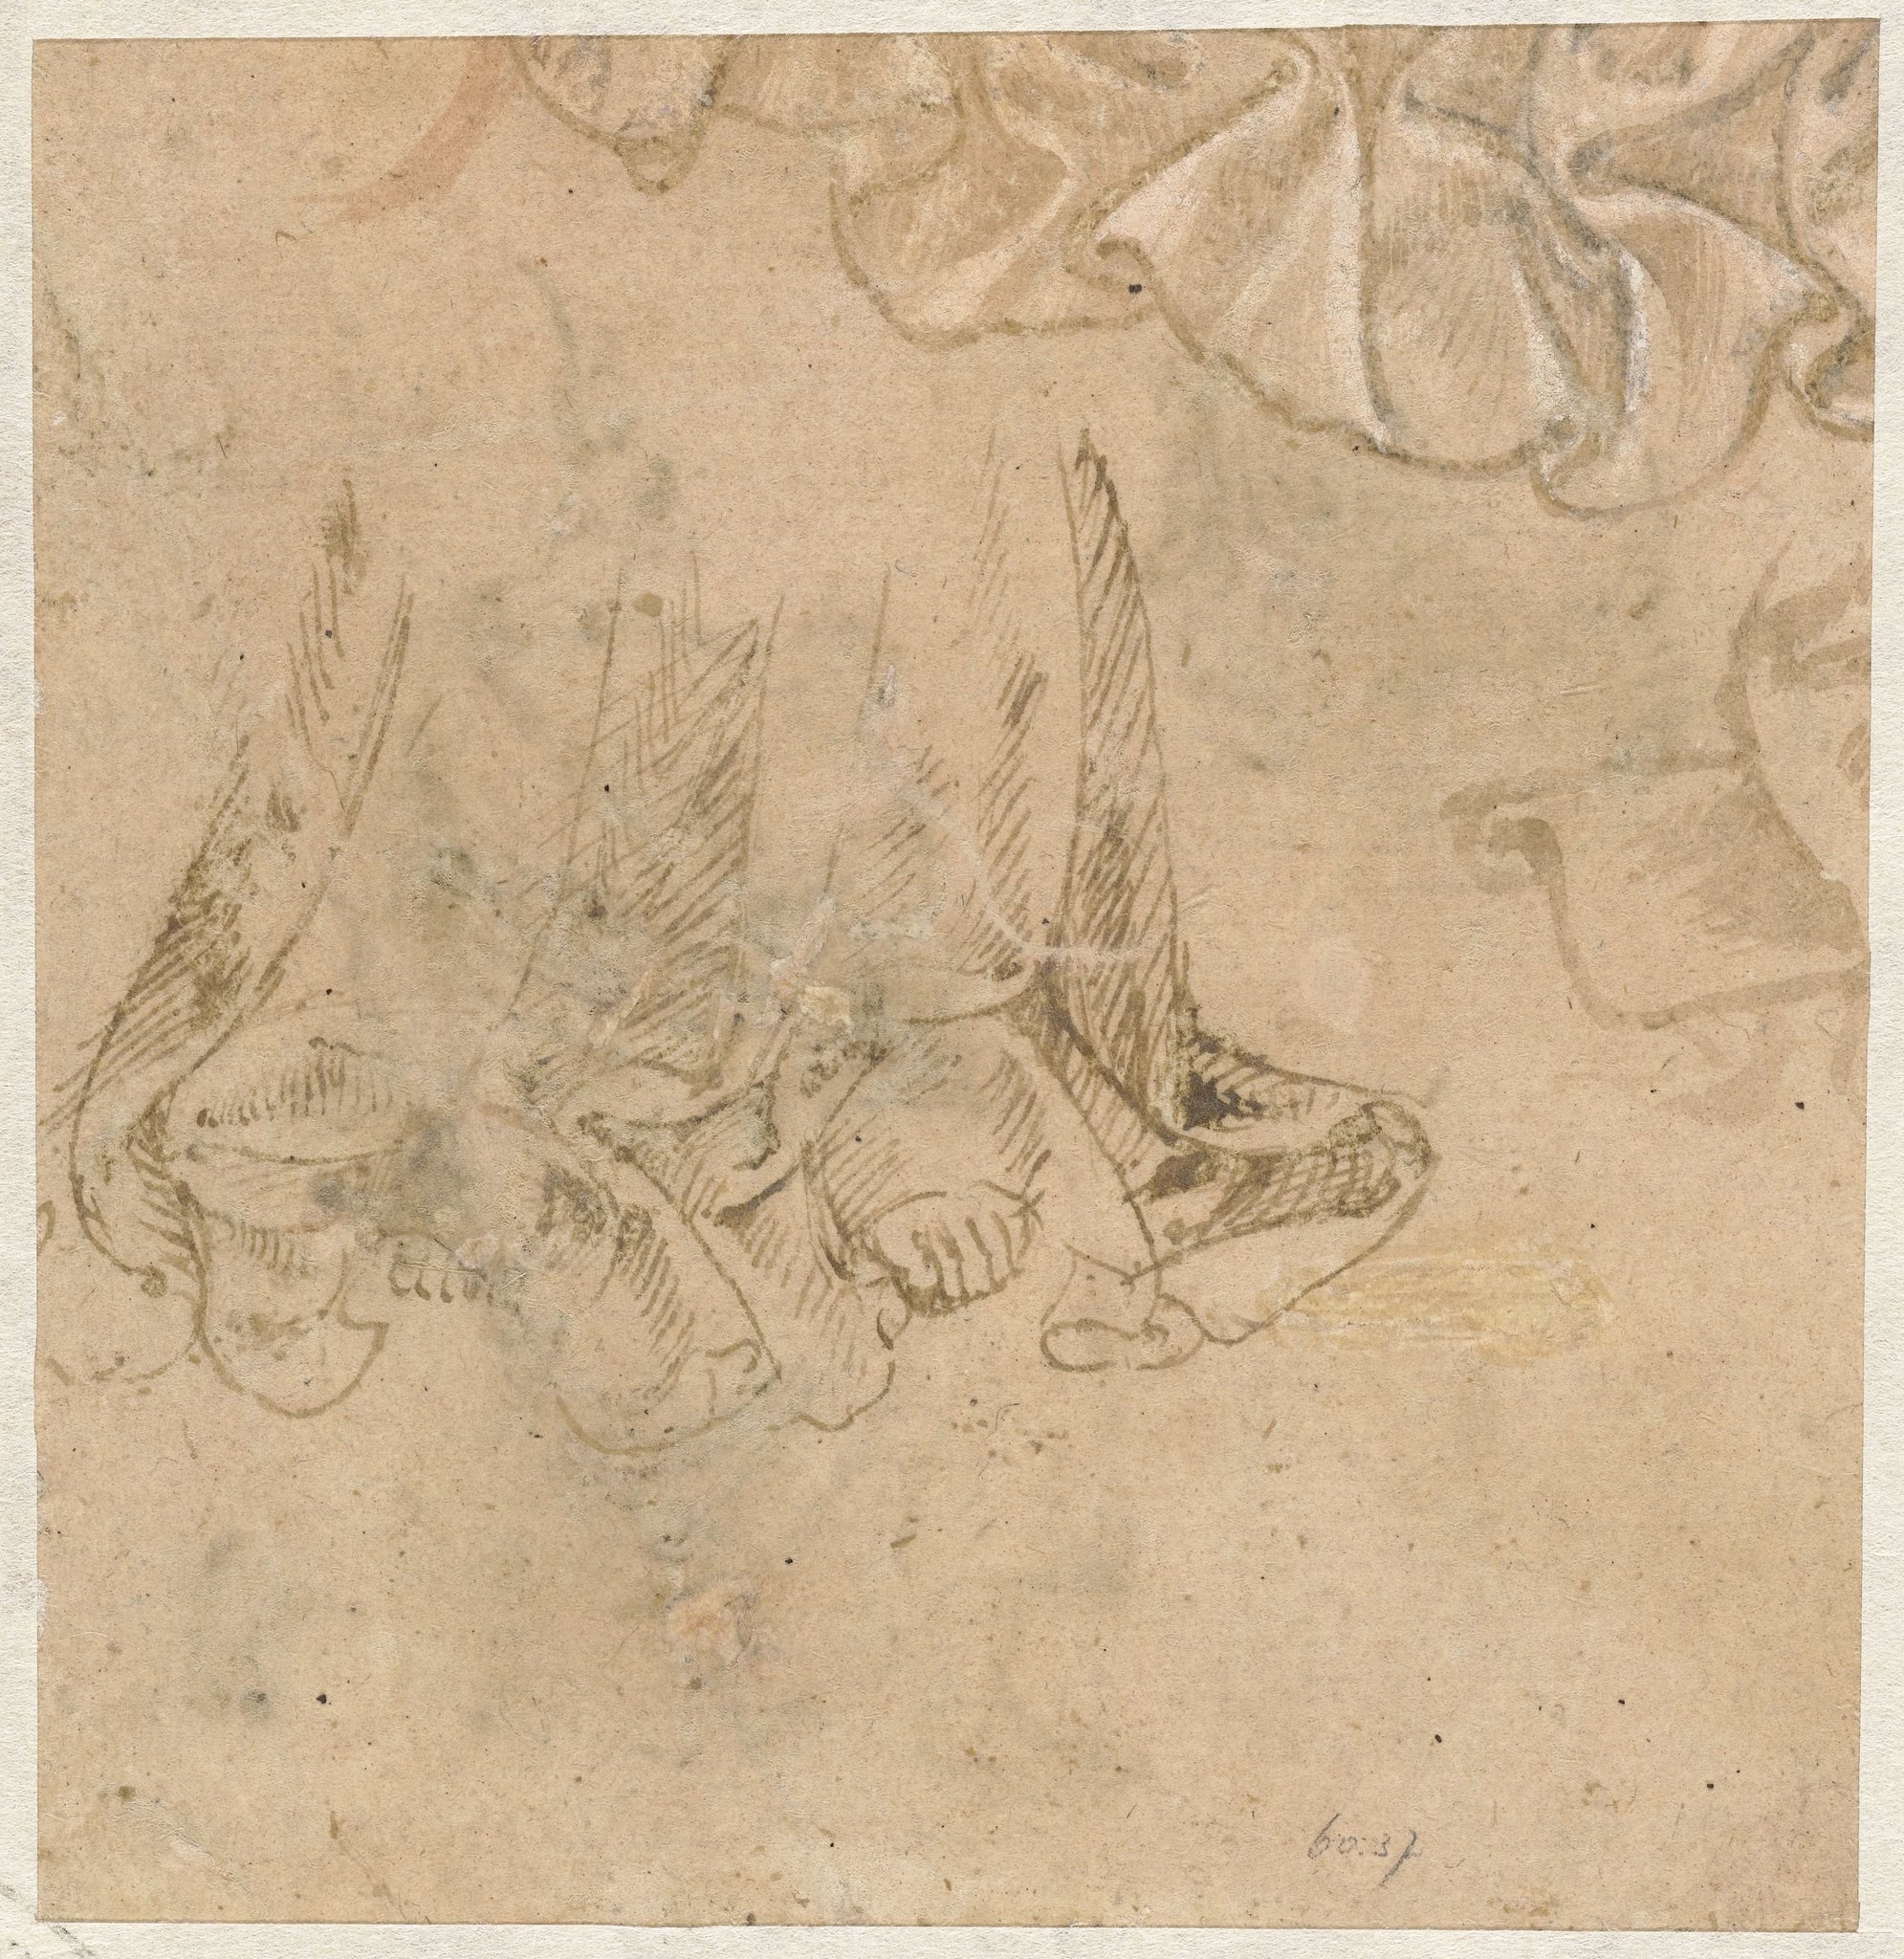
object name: drawing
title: Draperie-studies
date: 1450-1474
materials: ink, paper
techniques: pen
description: Blad uit een album met tekeningen van 15de-eeuwse kunstenaars uit Verona, Padua en Venetië.